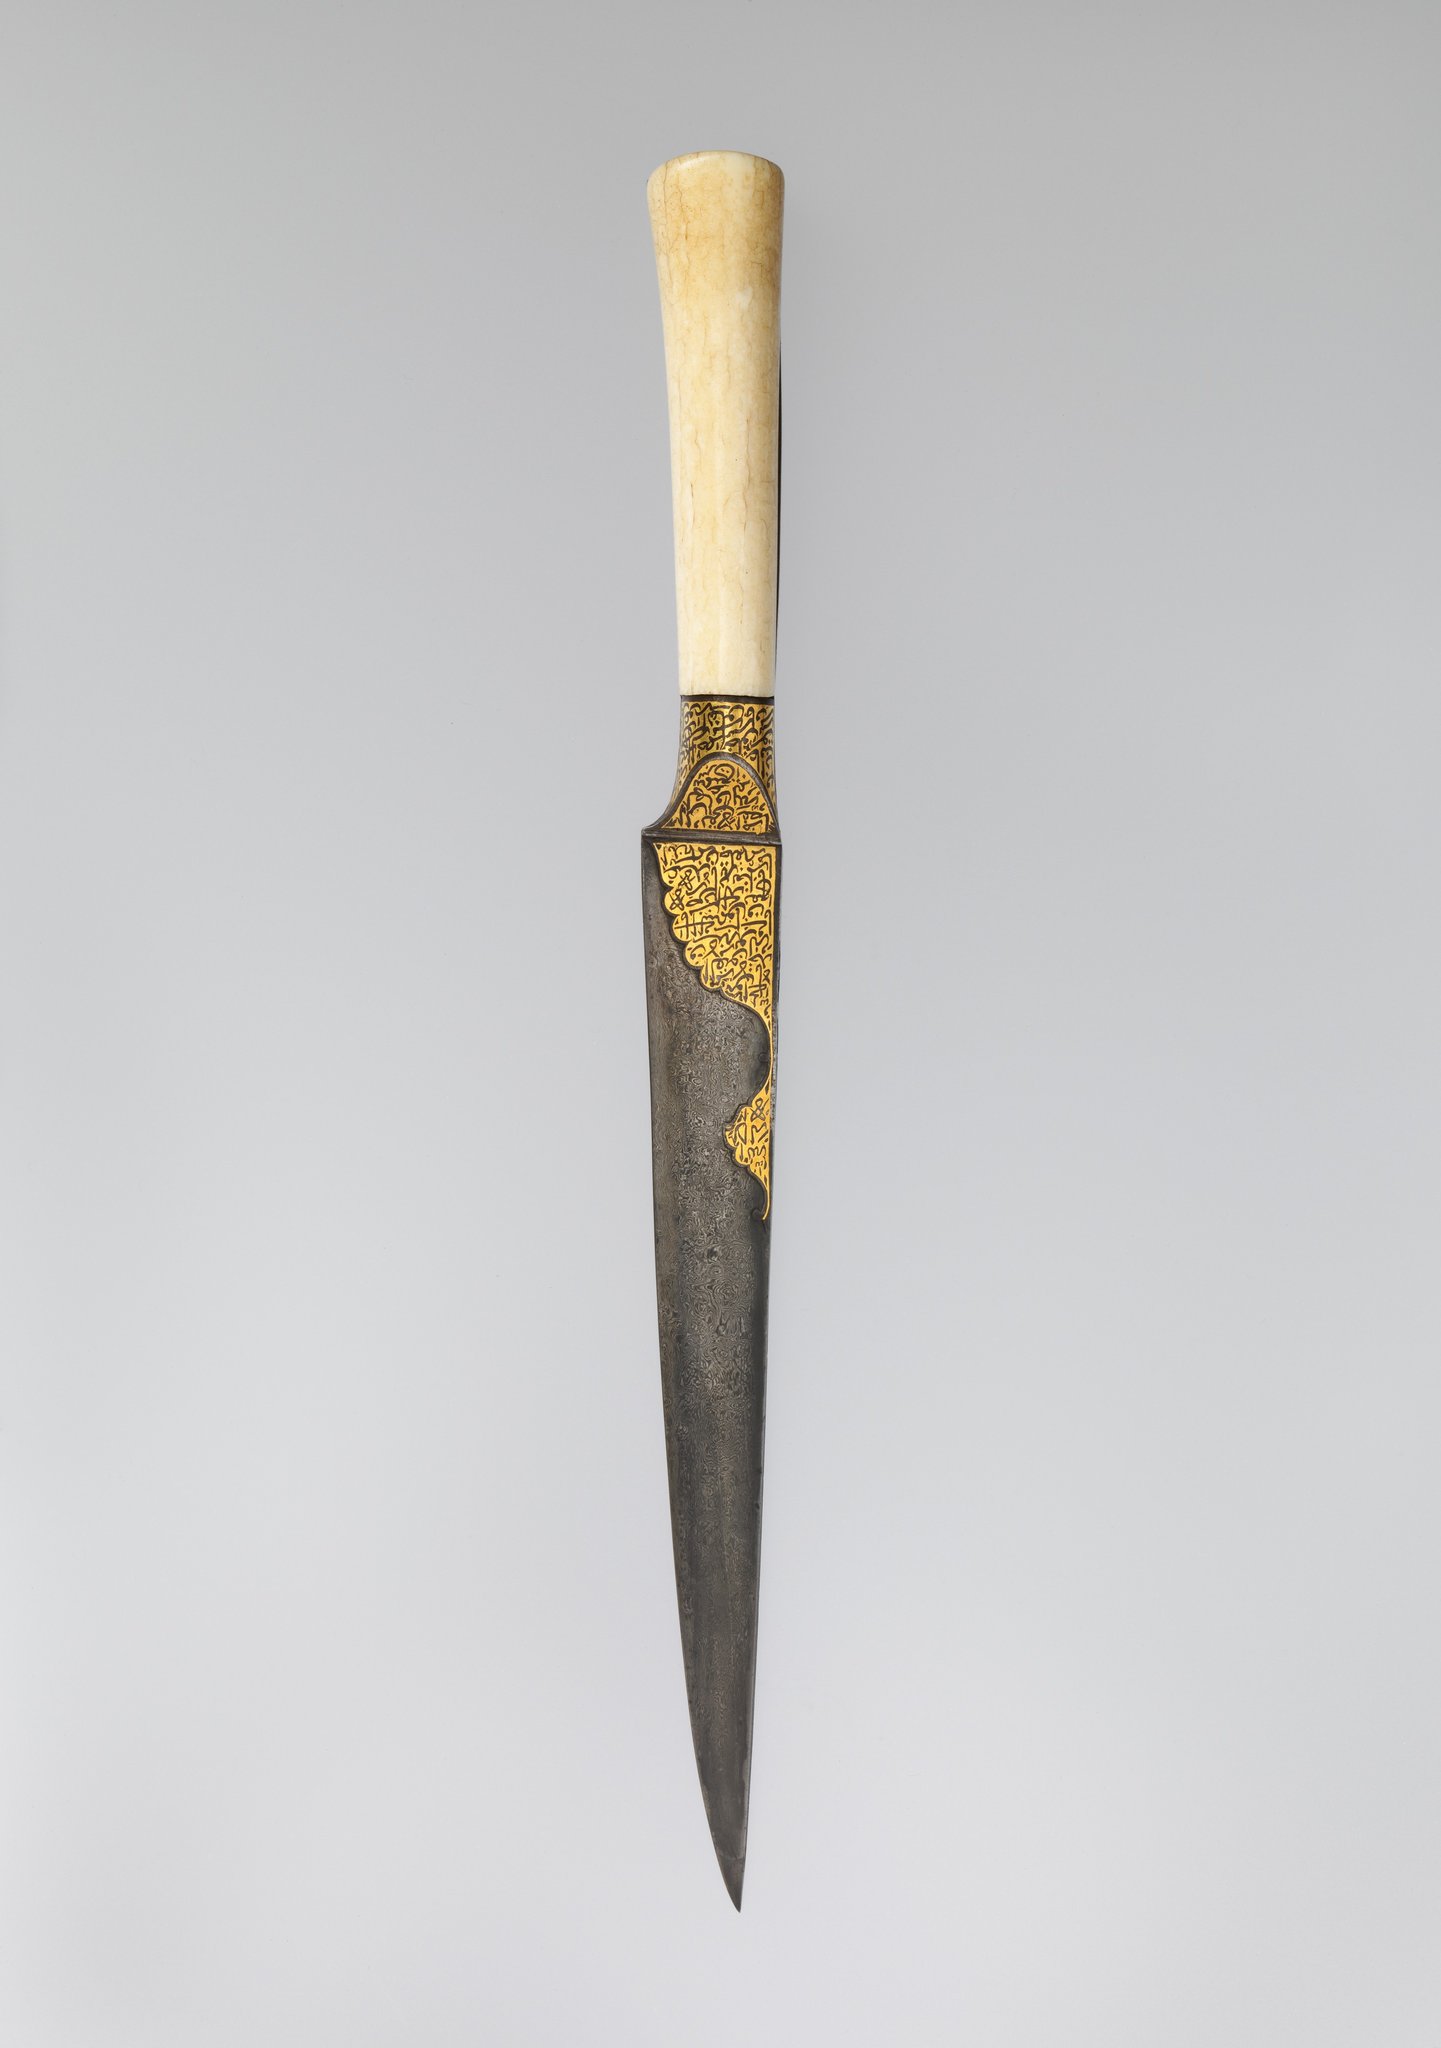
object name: dagger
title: Knife with an Ivory Handle and Qur'anic Inscriptions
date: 1801-1833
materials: gold, ivory, steel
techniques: inlay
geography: iran